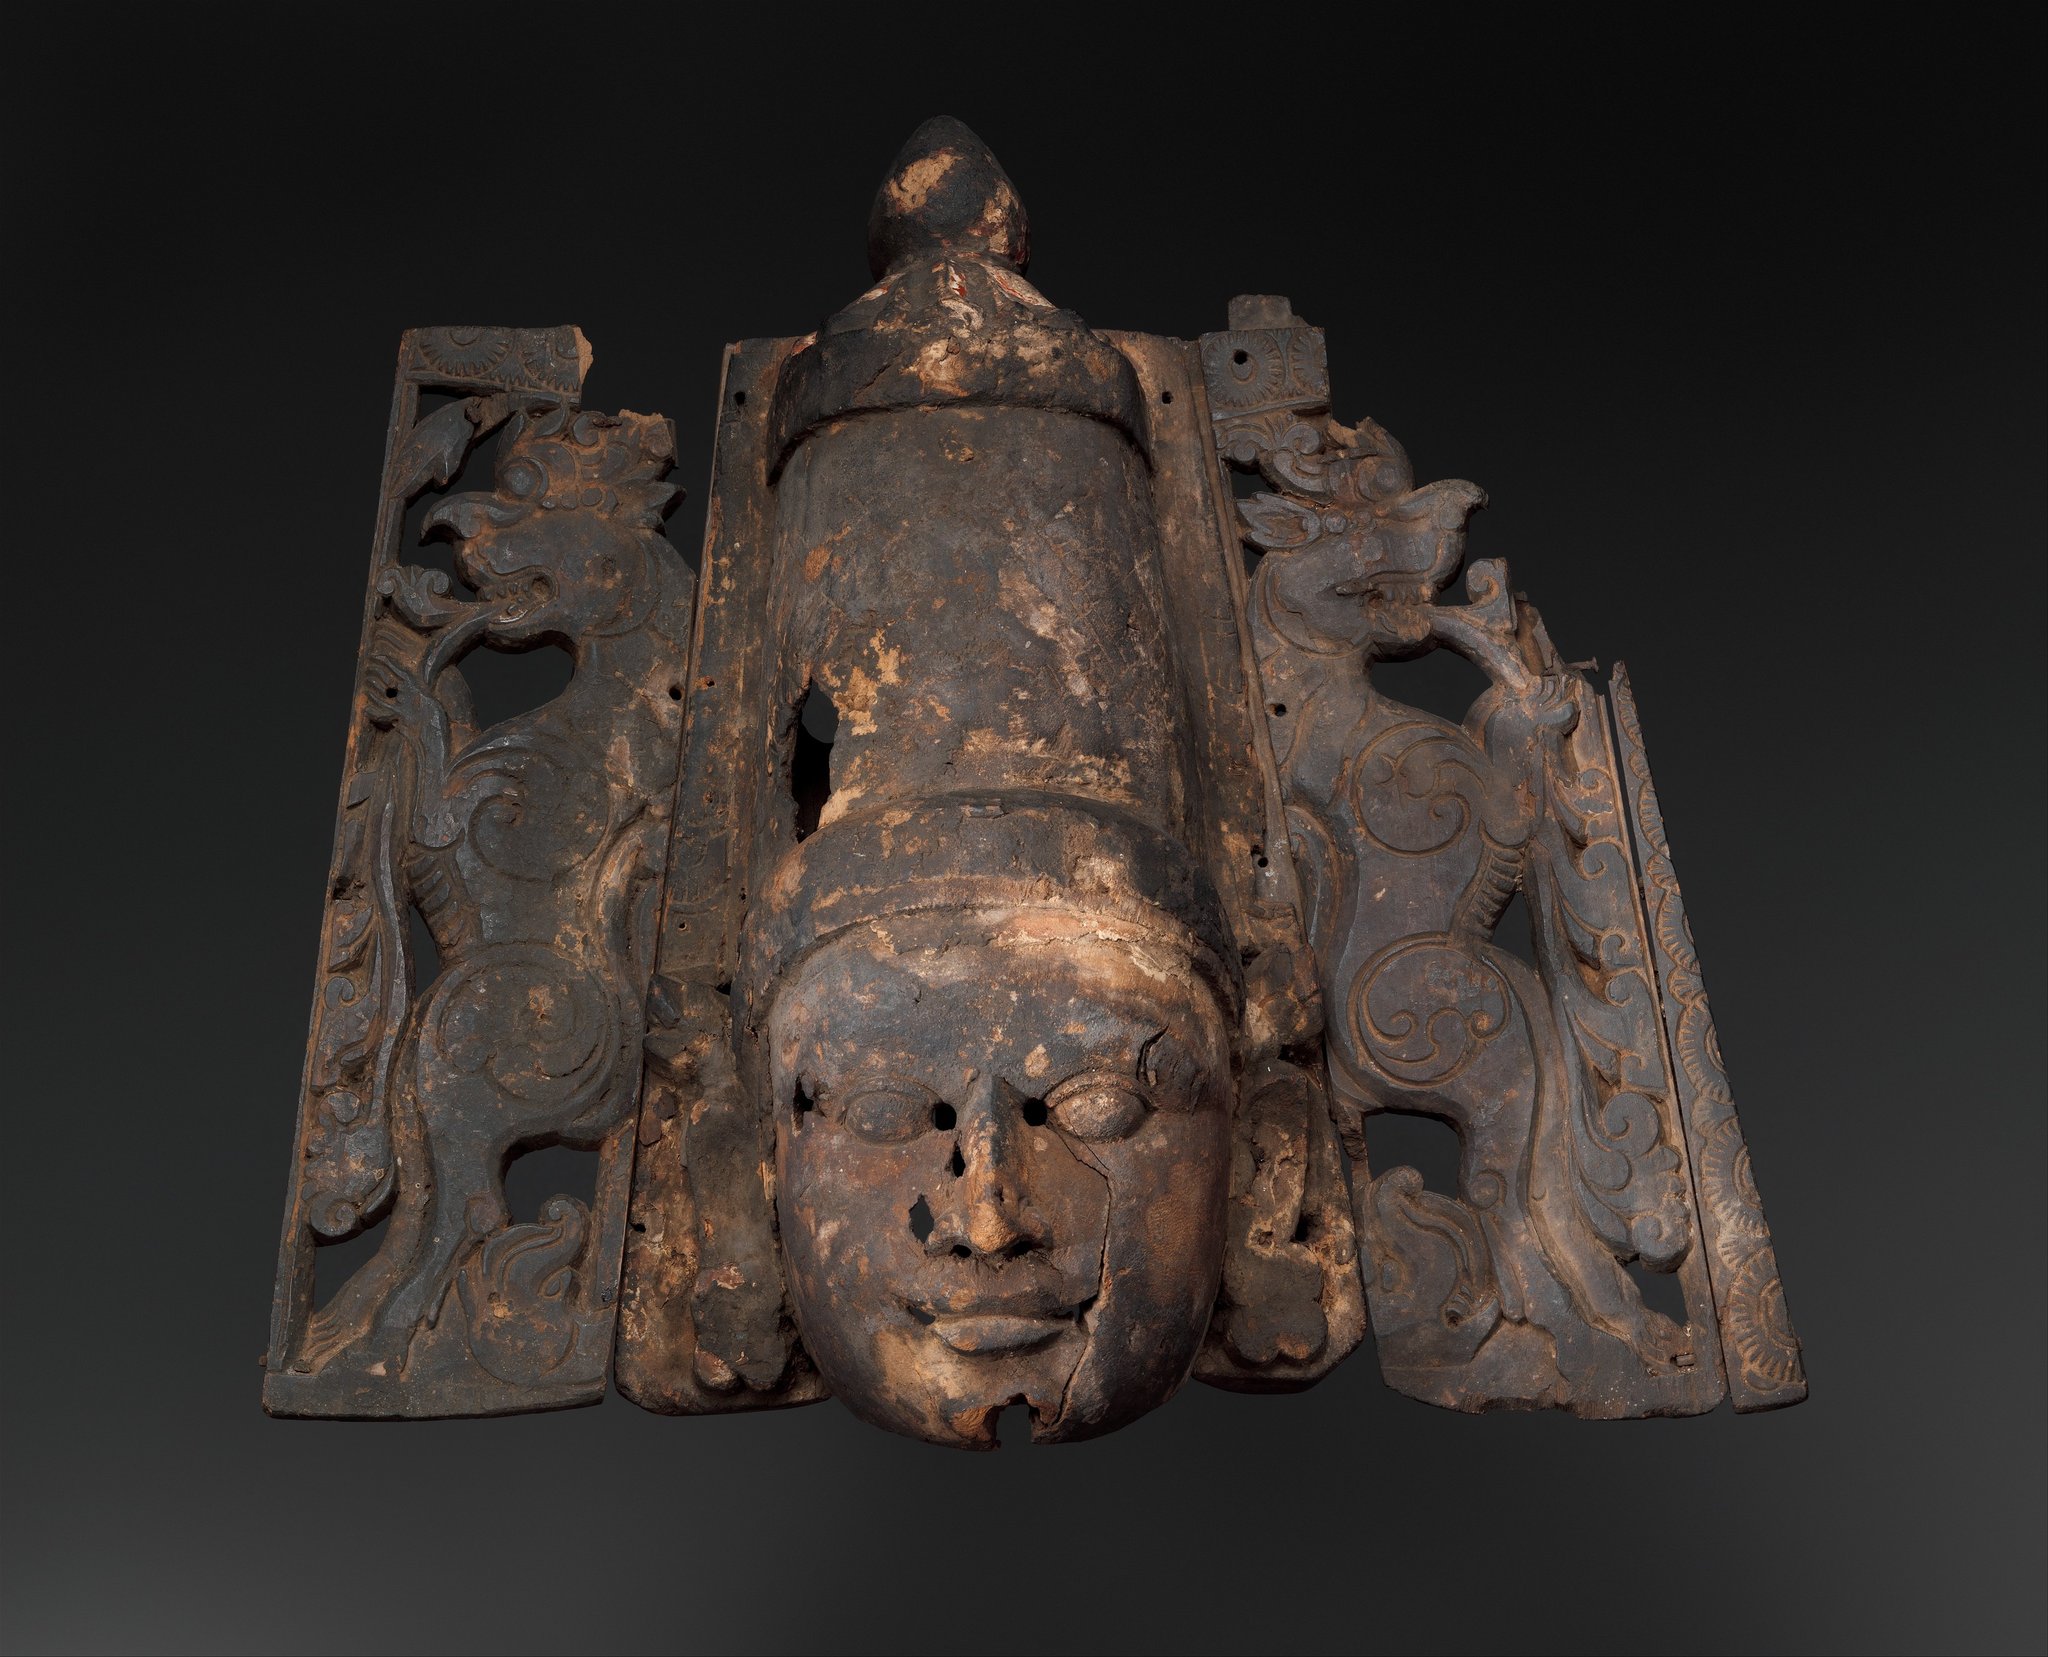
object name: mask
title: Vishnu or Prahalada, Son of Hiranyakashipu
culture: indian, southern, tamil nadu, thanjavur district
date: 1700-1750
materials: textile, wood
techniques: polychrome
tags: masks,vishnu